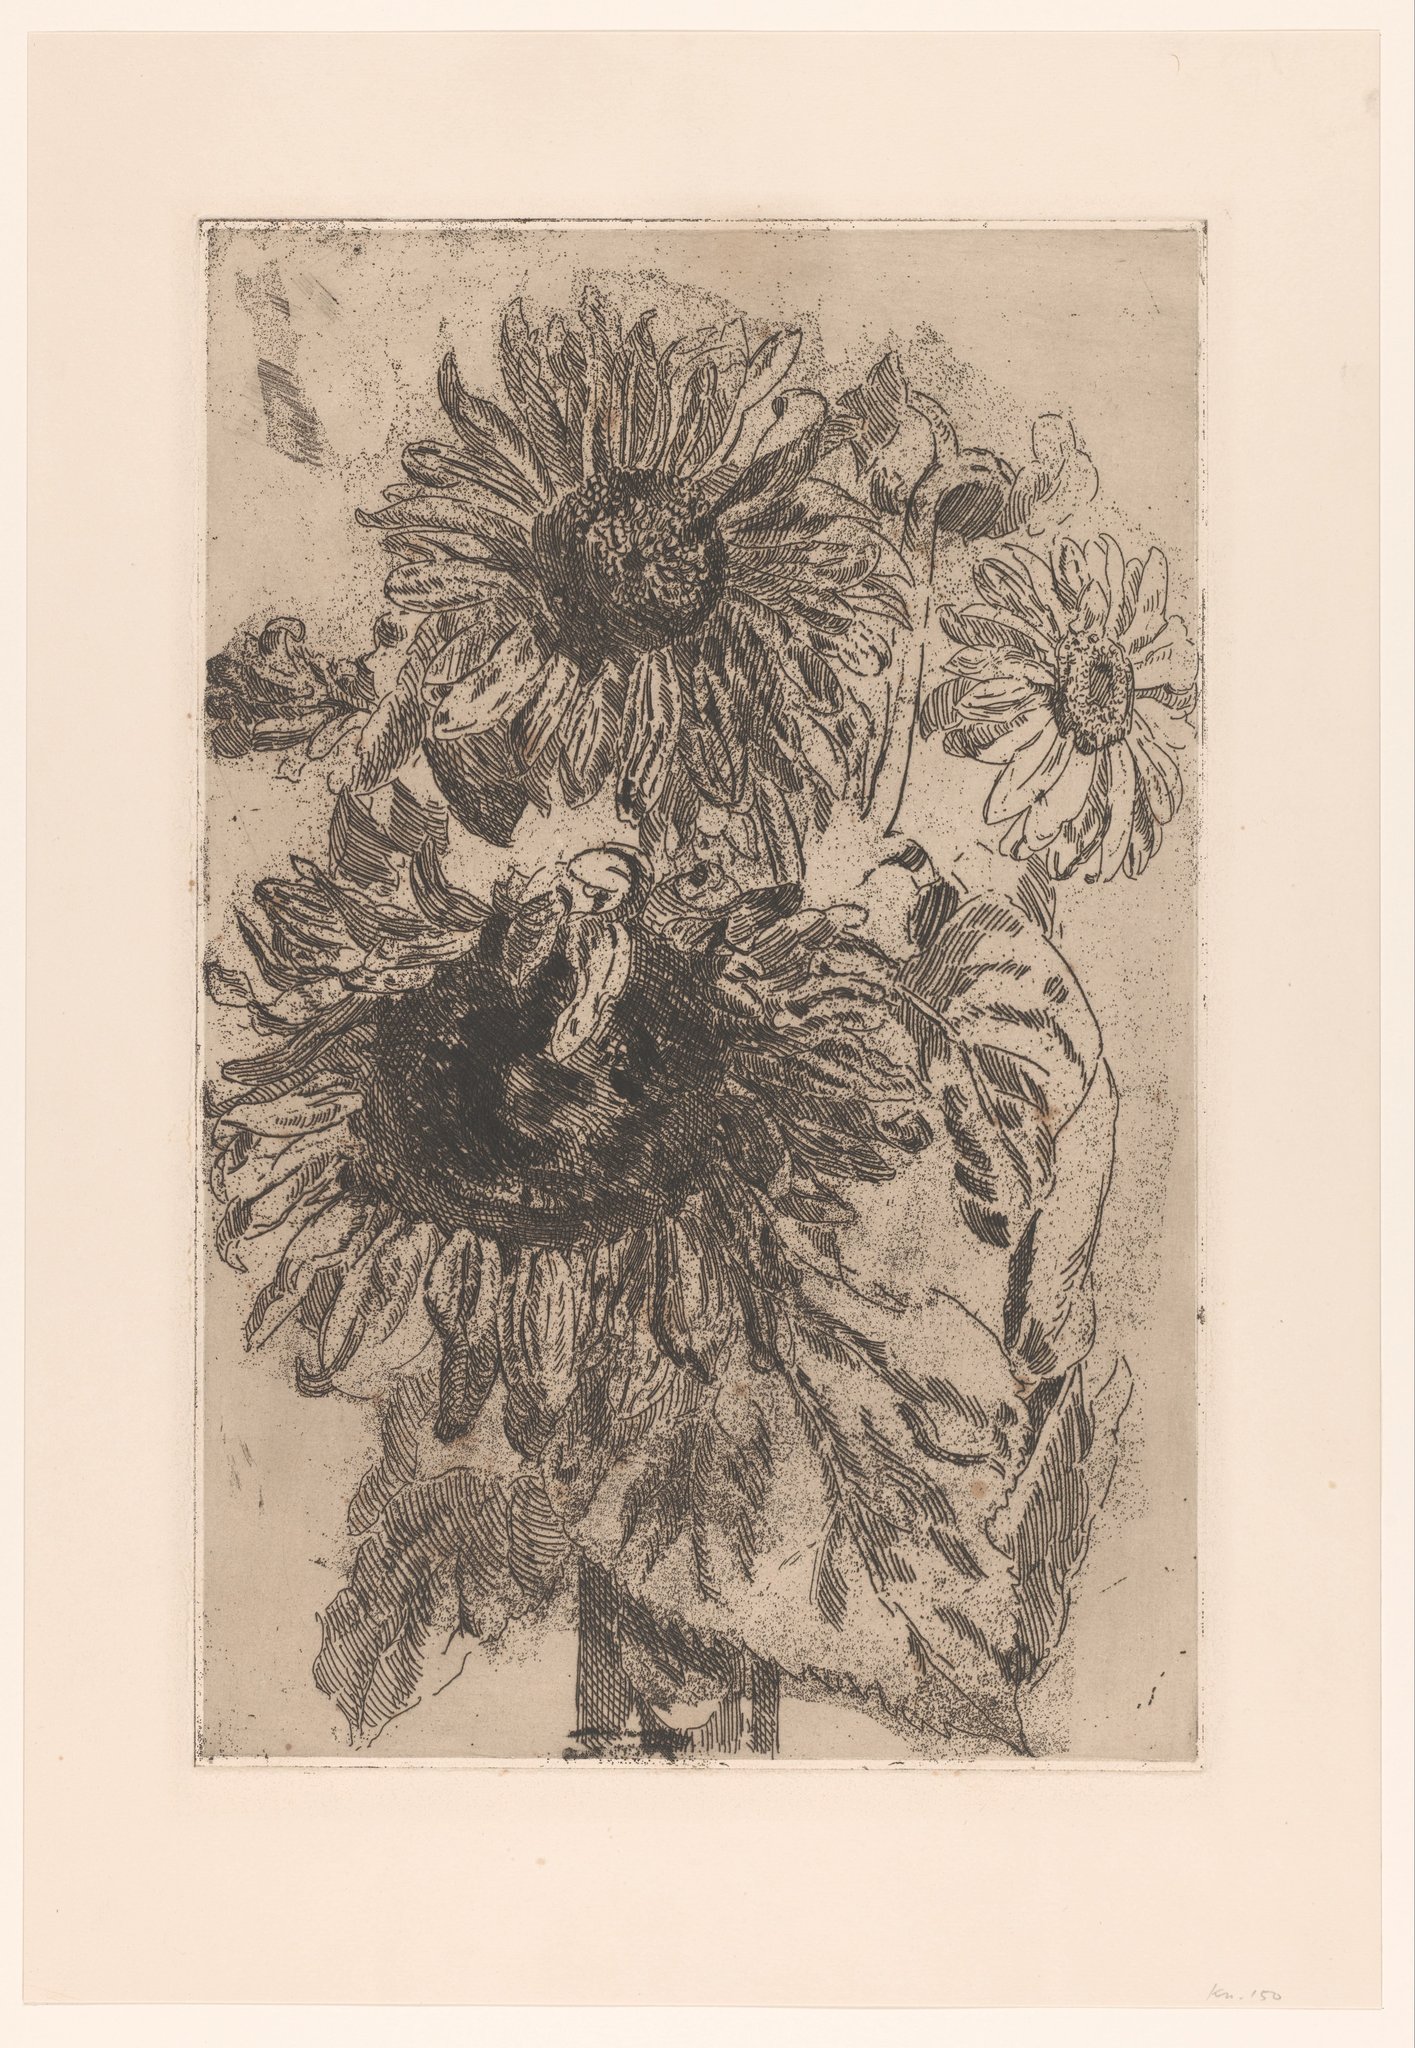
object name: print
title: Drie zonnebloemen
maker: barbara elisabeth van houten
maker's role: draughtsman, print maker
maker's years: 1862-1950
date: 1872-1950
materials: paper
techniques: etching, intaglio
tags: flowers: sunflower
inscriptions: collector's mark: Lugt 2228